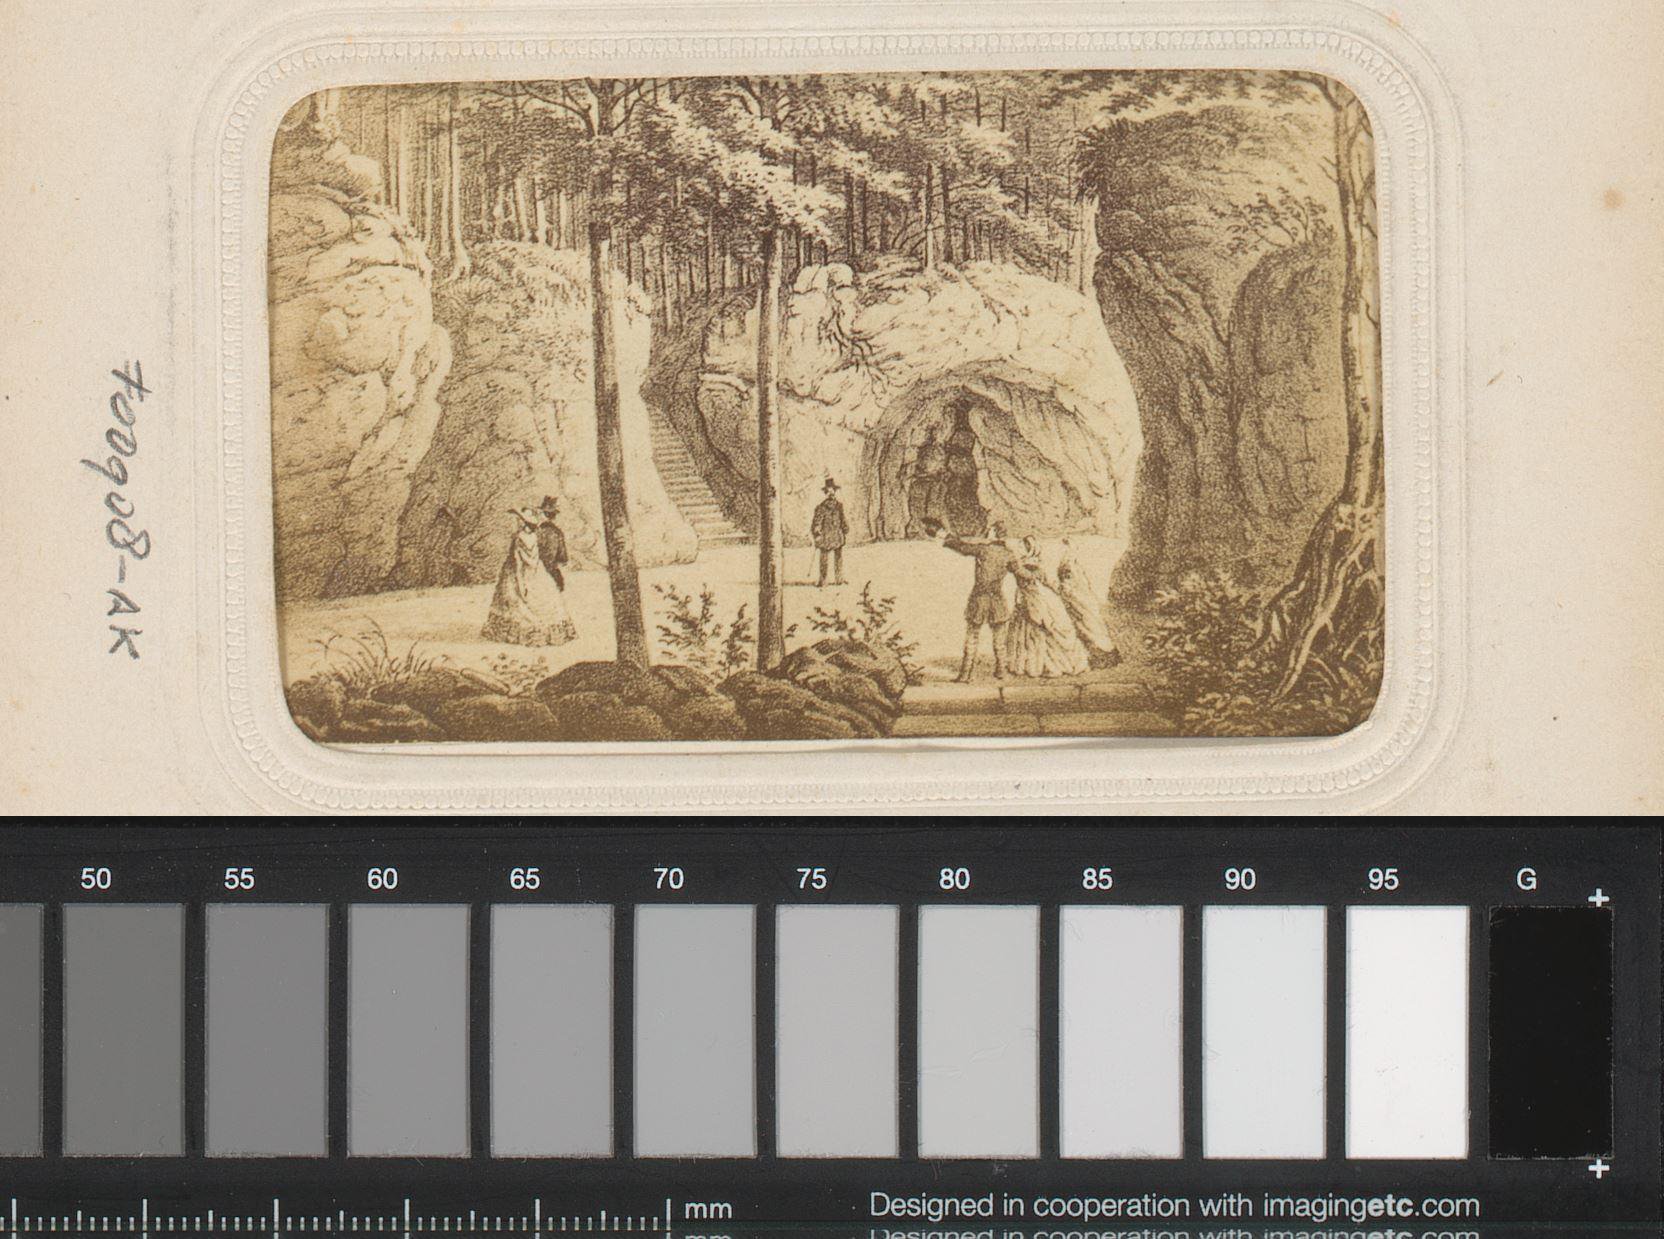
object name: photograph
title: Fotoreproductie van een prent van het Felsentheater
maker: Anonymous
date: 1860-1885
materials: cardboard, photographic support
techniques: albumen print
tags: flight of steps, forest, wood, rocks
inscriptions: annotation: ‘[...]’, annotation: ‘Felsentheater bij Liebestein’, inscription: ‘Felsentheater’